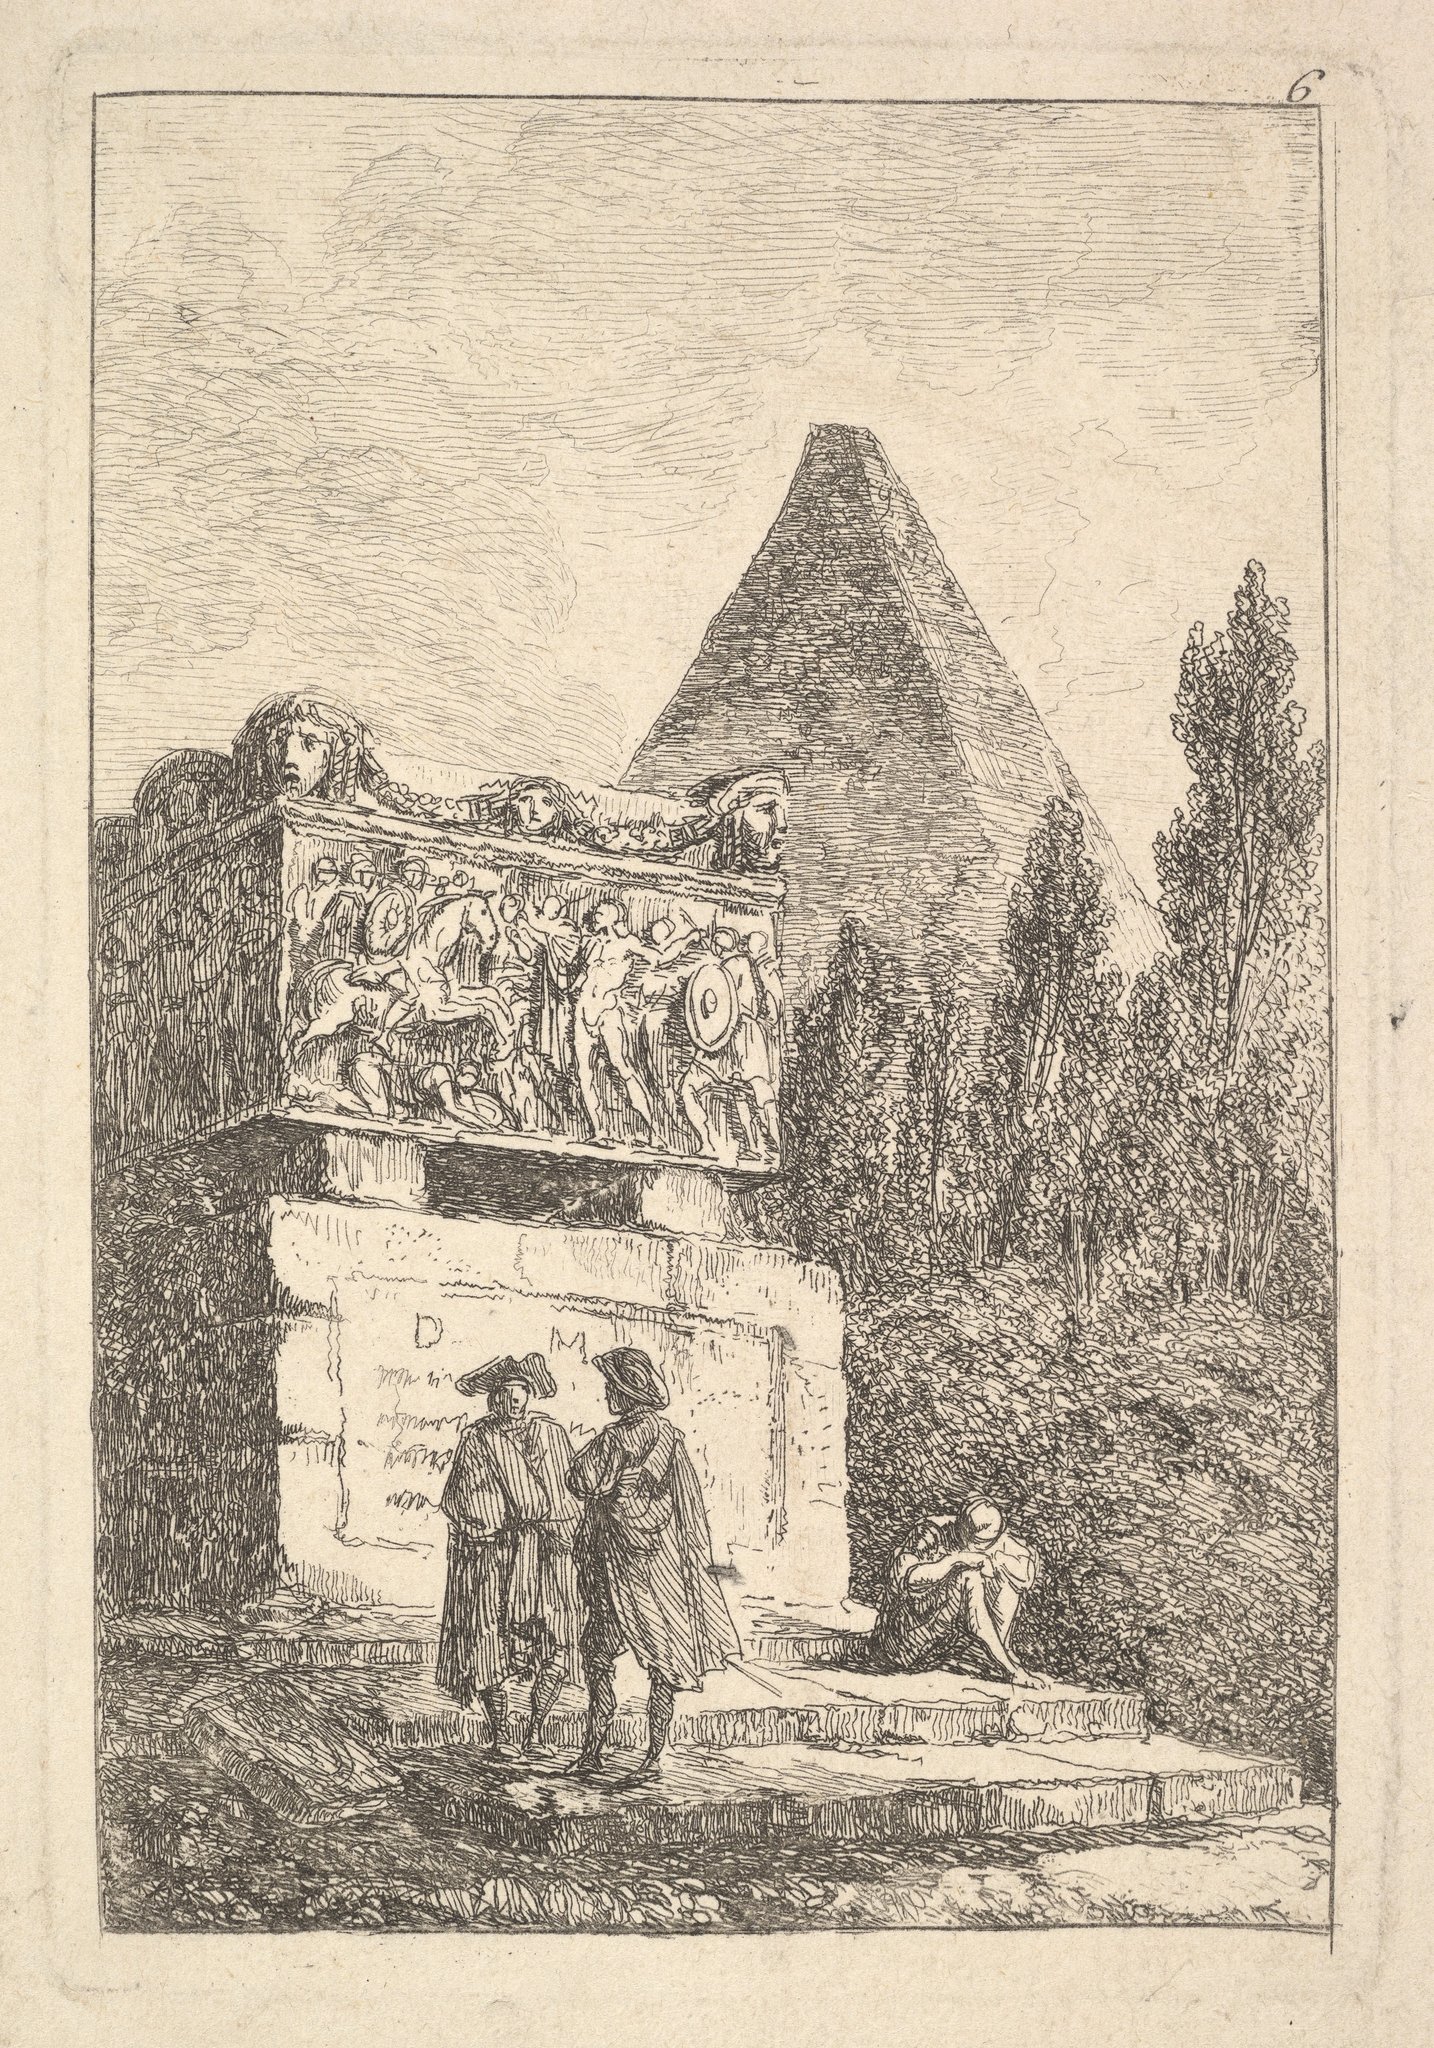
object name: print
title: Plate 6: The Sarcophagus: two men conversing to left, another man seated and sleeping to right, an ancient sarcophagus to left decorated with reliefs, a pyramid to right in the background half-hidden by cyprus trees, from "Les soirées de Rome"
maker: hubert robert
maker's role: artist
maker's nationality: french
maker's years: 1733-1808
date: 1763-1764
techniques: etching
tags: tombs,heads,men,sarcophagus